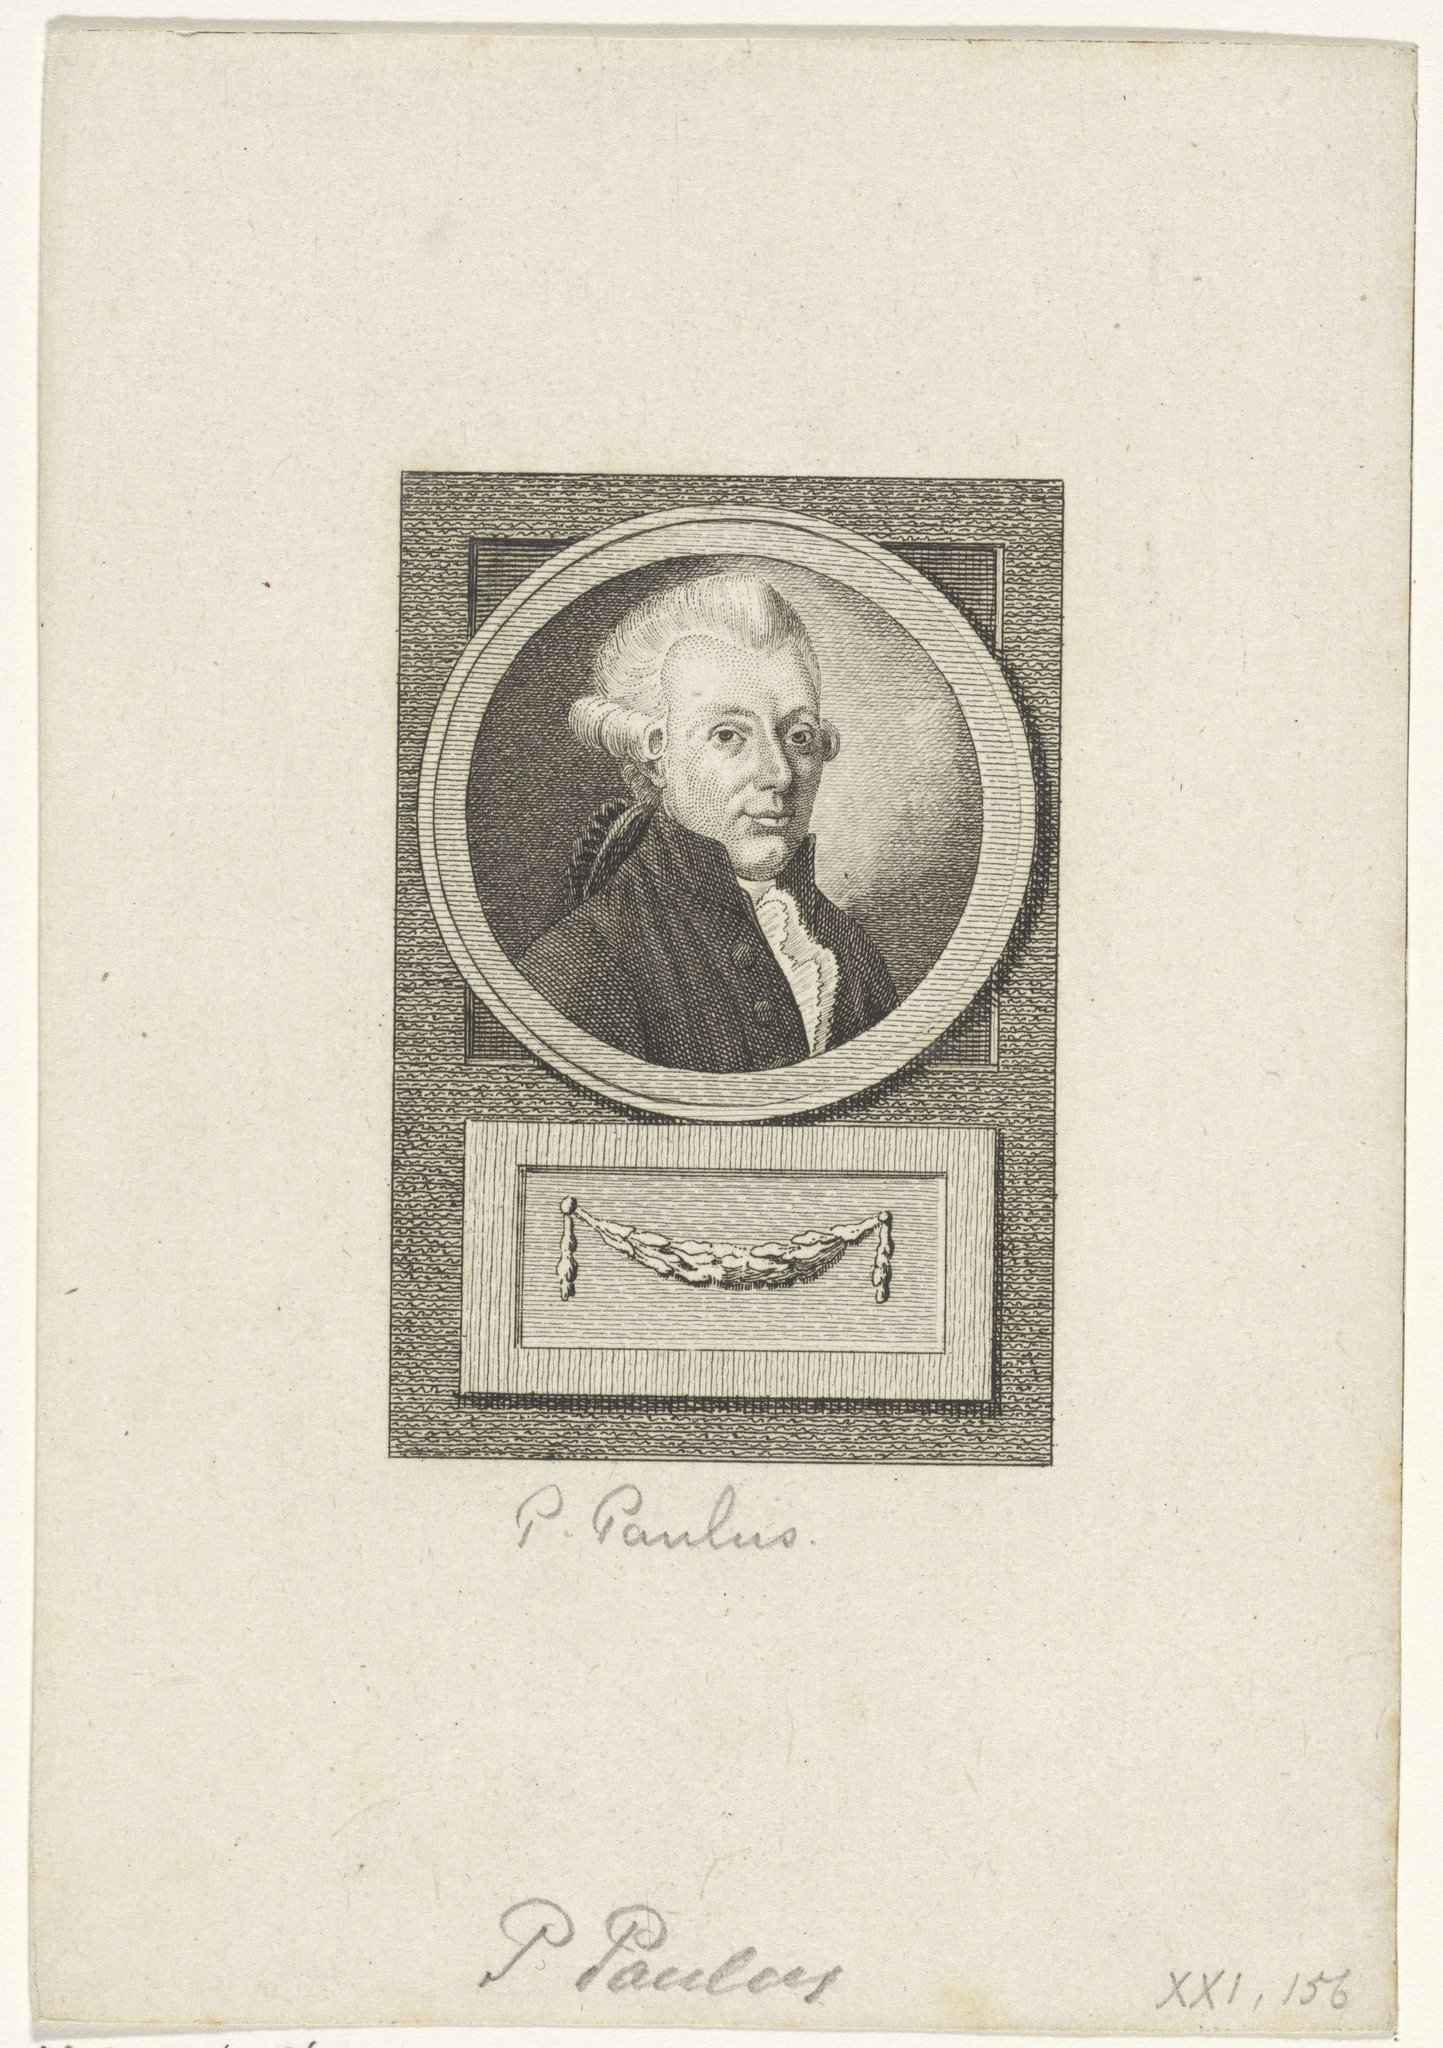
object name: print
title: Portret van Pieter Paulus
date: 1783-1795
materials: paper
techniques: engraving, etching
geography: amsterdam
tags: the hague, pieter paulus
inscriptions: collector's mark: Lugt 2228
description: Latere staat prent gebruikt in: Fokke, Jan. Geschiedenissen der Vereenigde Nederlanden voor de vaderlandsche jeugd Ie-XXVste deel. Amsterdam: Johannes Allart, 1783-1795. Deel XXII.